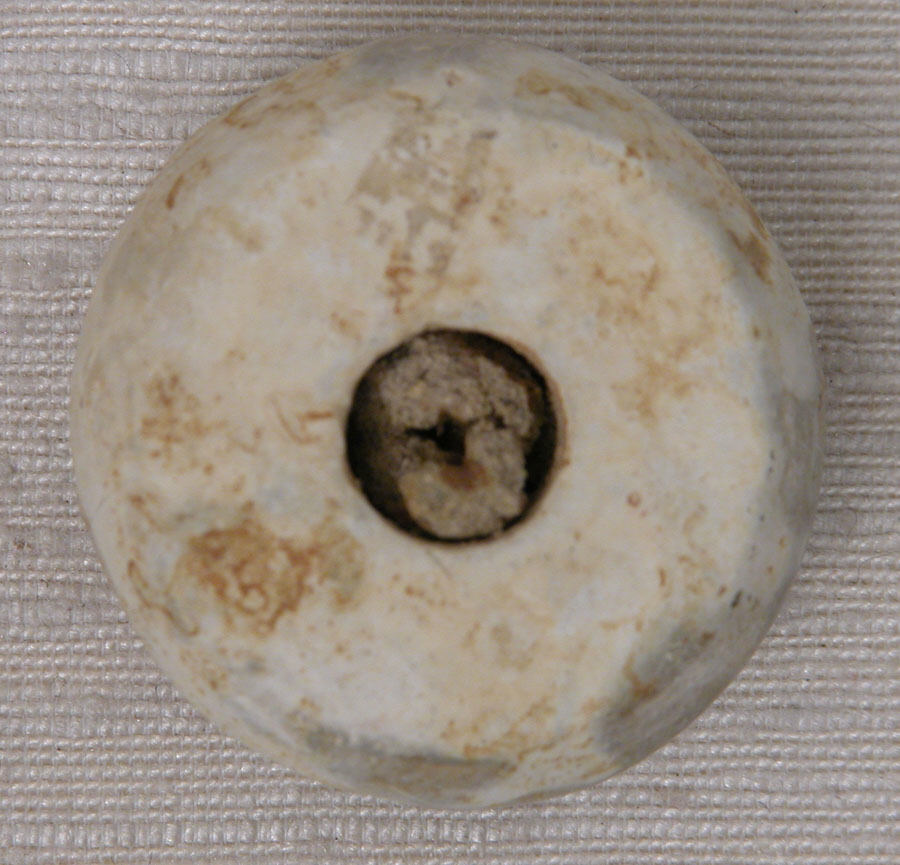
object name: bead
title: Beads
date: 701-1300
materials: stone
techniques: cutting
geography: iran